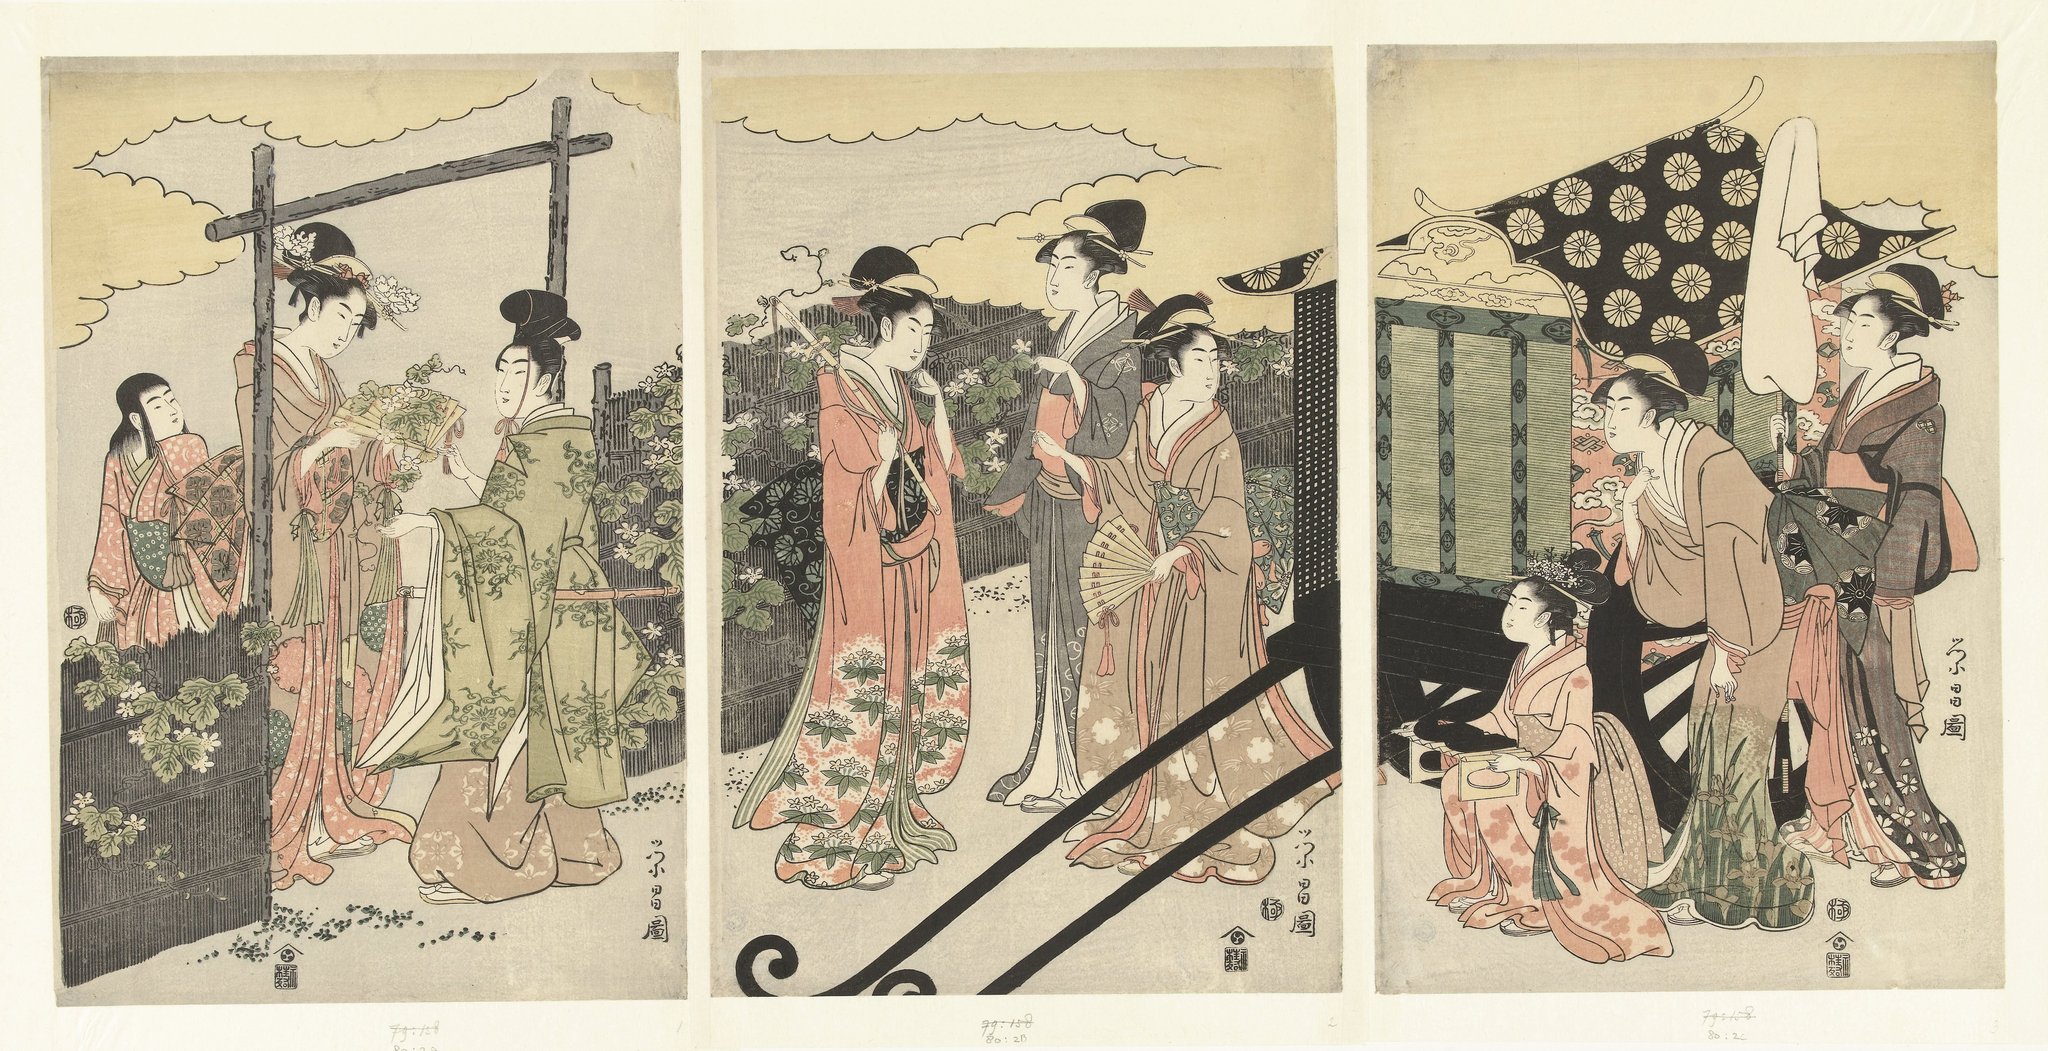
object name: print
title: Prins Genji en Yugao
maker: chokosai eishô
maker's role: print maker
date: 1795-1800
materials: paper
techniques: woodcut, nishiki e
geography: tokyo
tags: adult woman, gate, entrance, covered wagon, hooded wagon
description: Rijk geklede dame, met waaier waarop bloemen, bij poort pratend met hoveling, waarachter een rijtuig en toekijkende vrouwen.